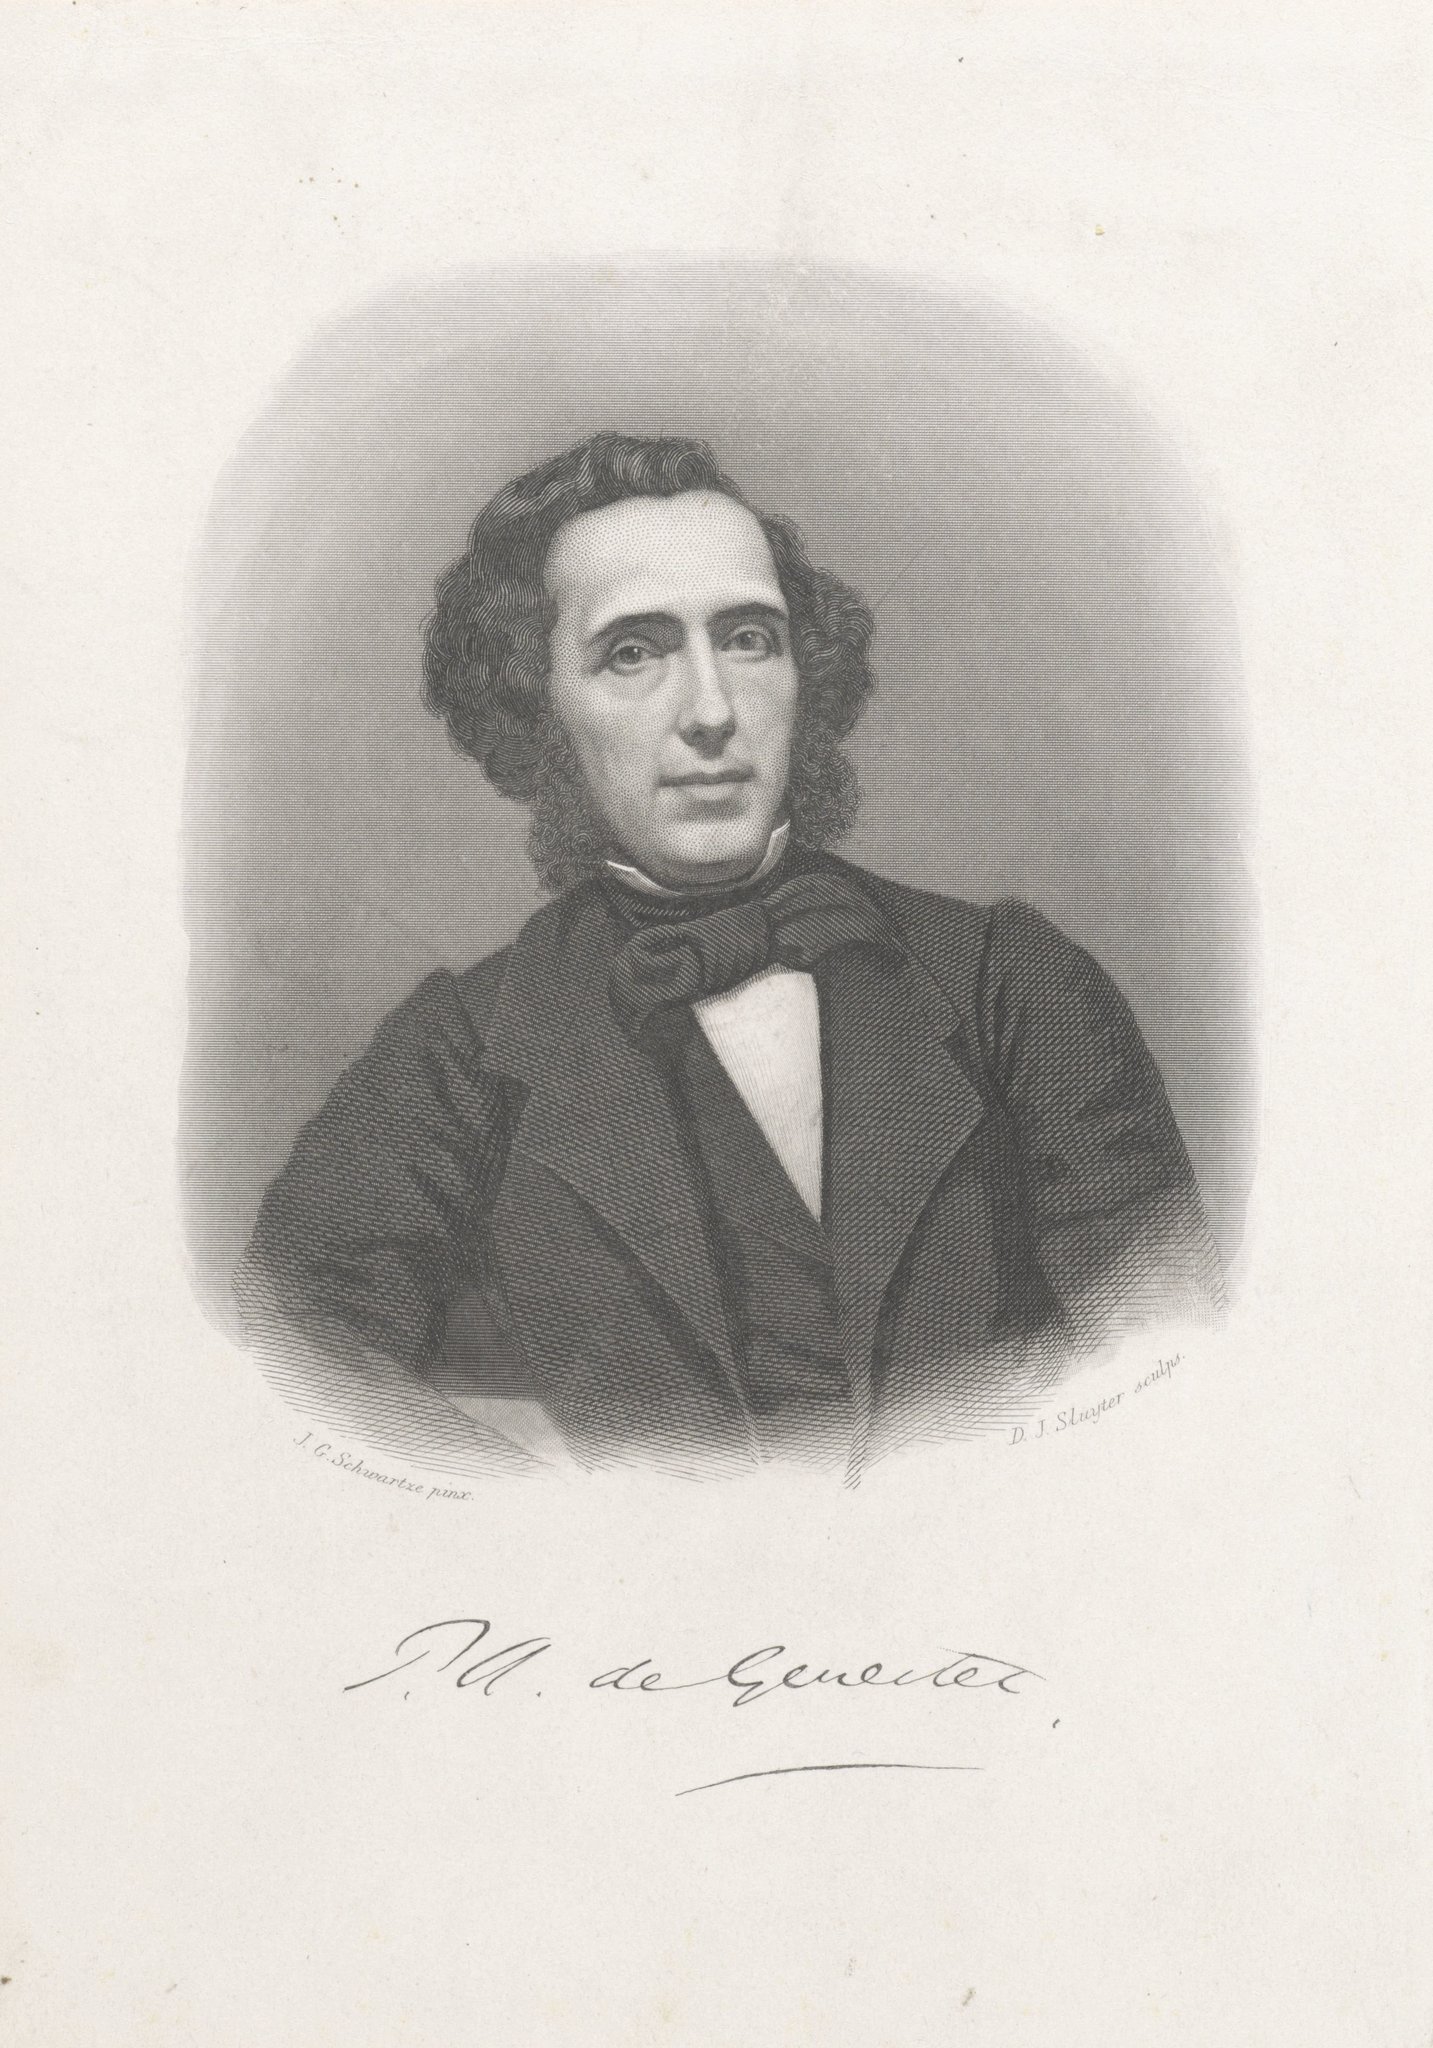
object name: print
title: Portret van de dichter en predikant Petrus Augustus de Génestet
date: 1855-1886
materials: paper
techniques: etching, engraving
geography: amsterdam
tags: amsterdam, petrus augustus de génestet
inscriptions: collector's mark: Lugt 2228